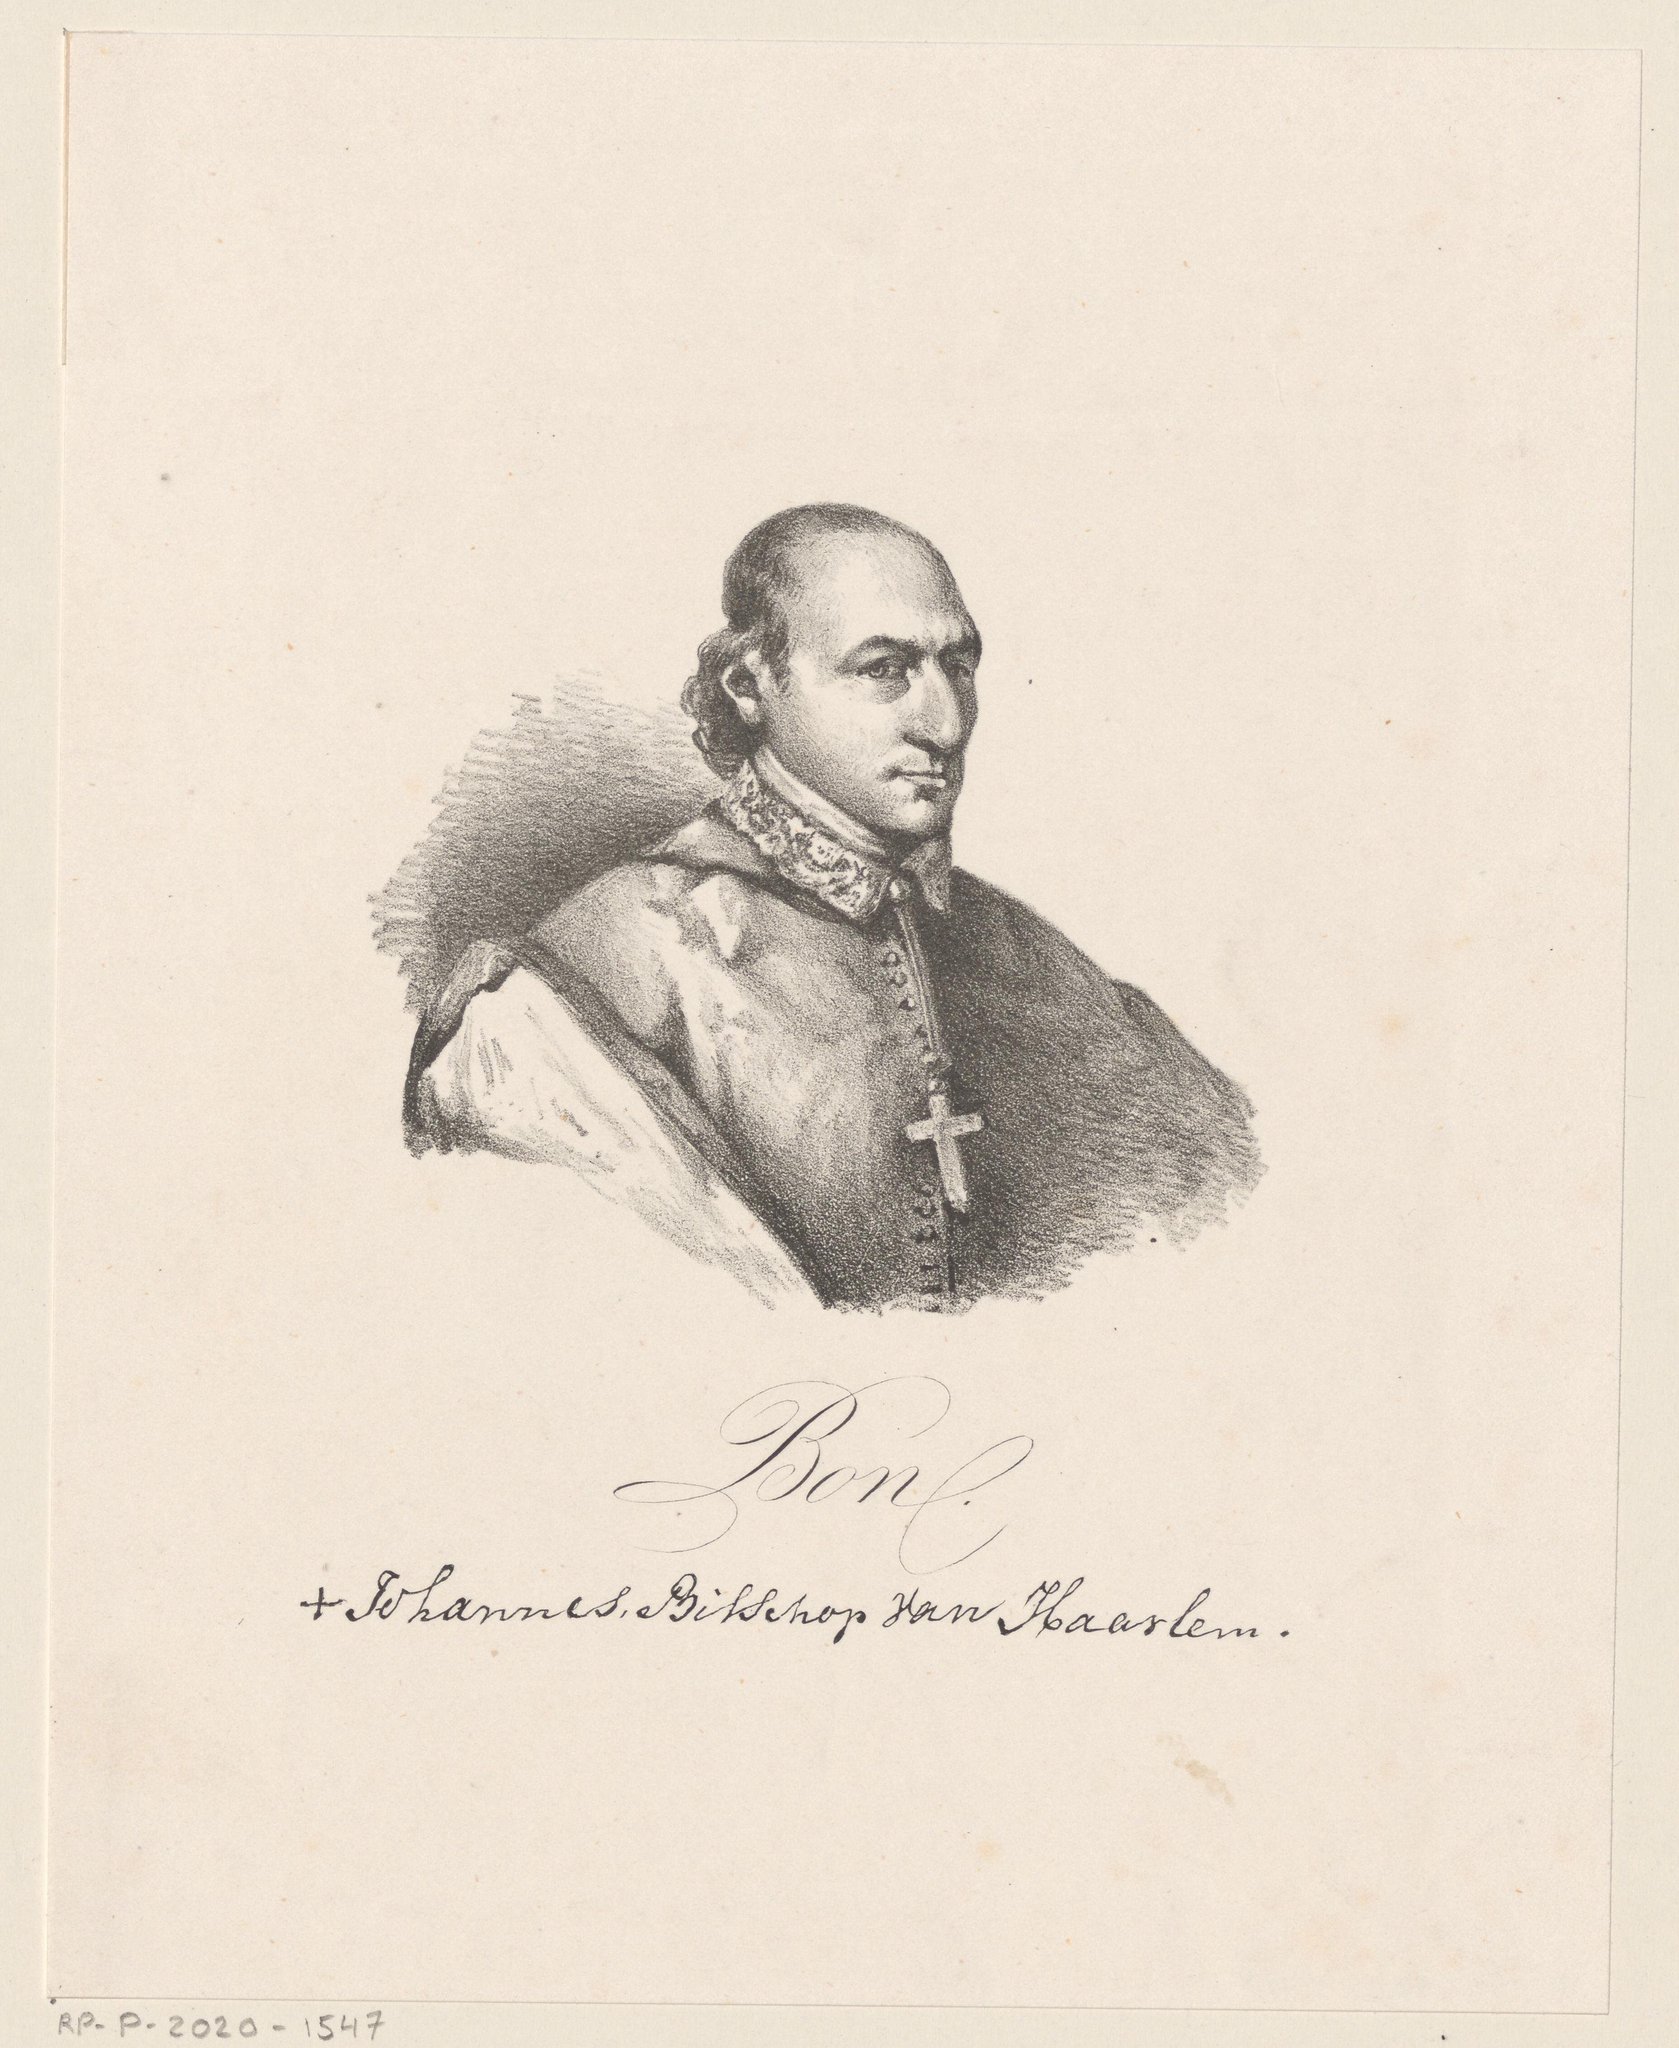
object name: print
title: Portret van Johannes Bon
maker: Anonymous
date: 1815-1849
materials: paper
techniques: lithograph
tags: archbishop, bishop, etc. (roman catholic), historical persons